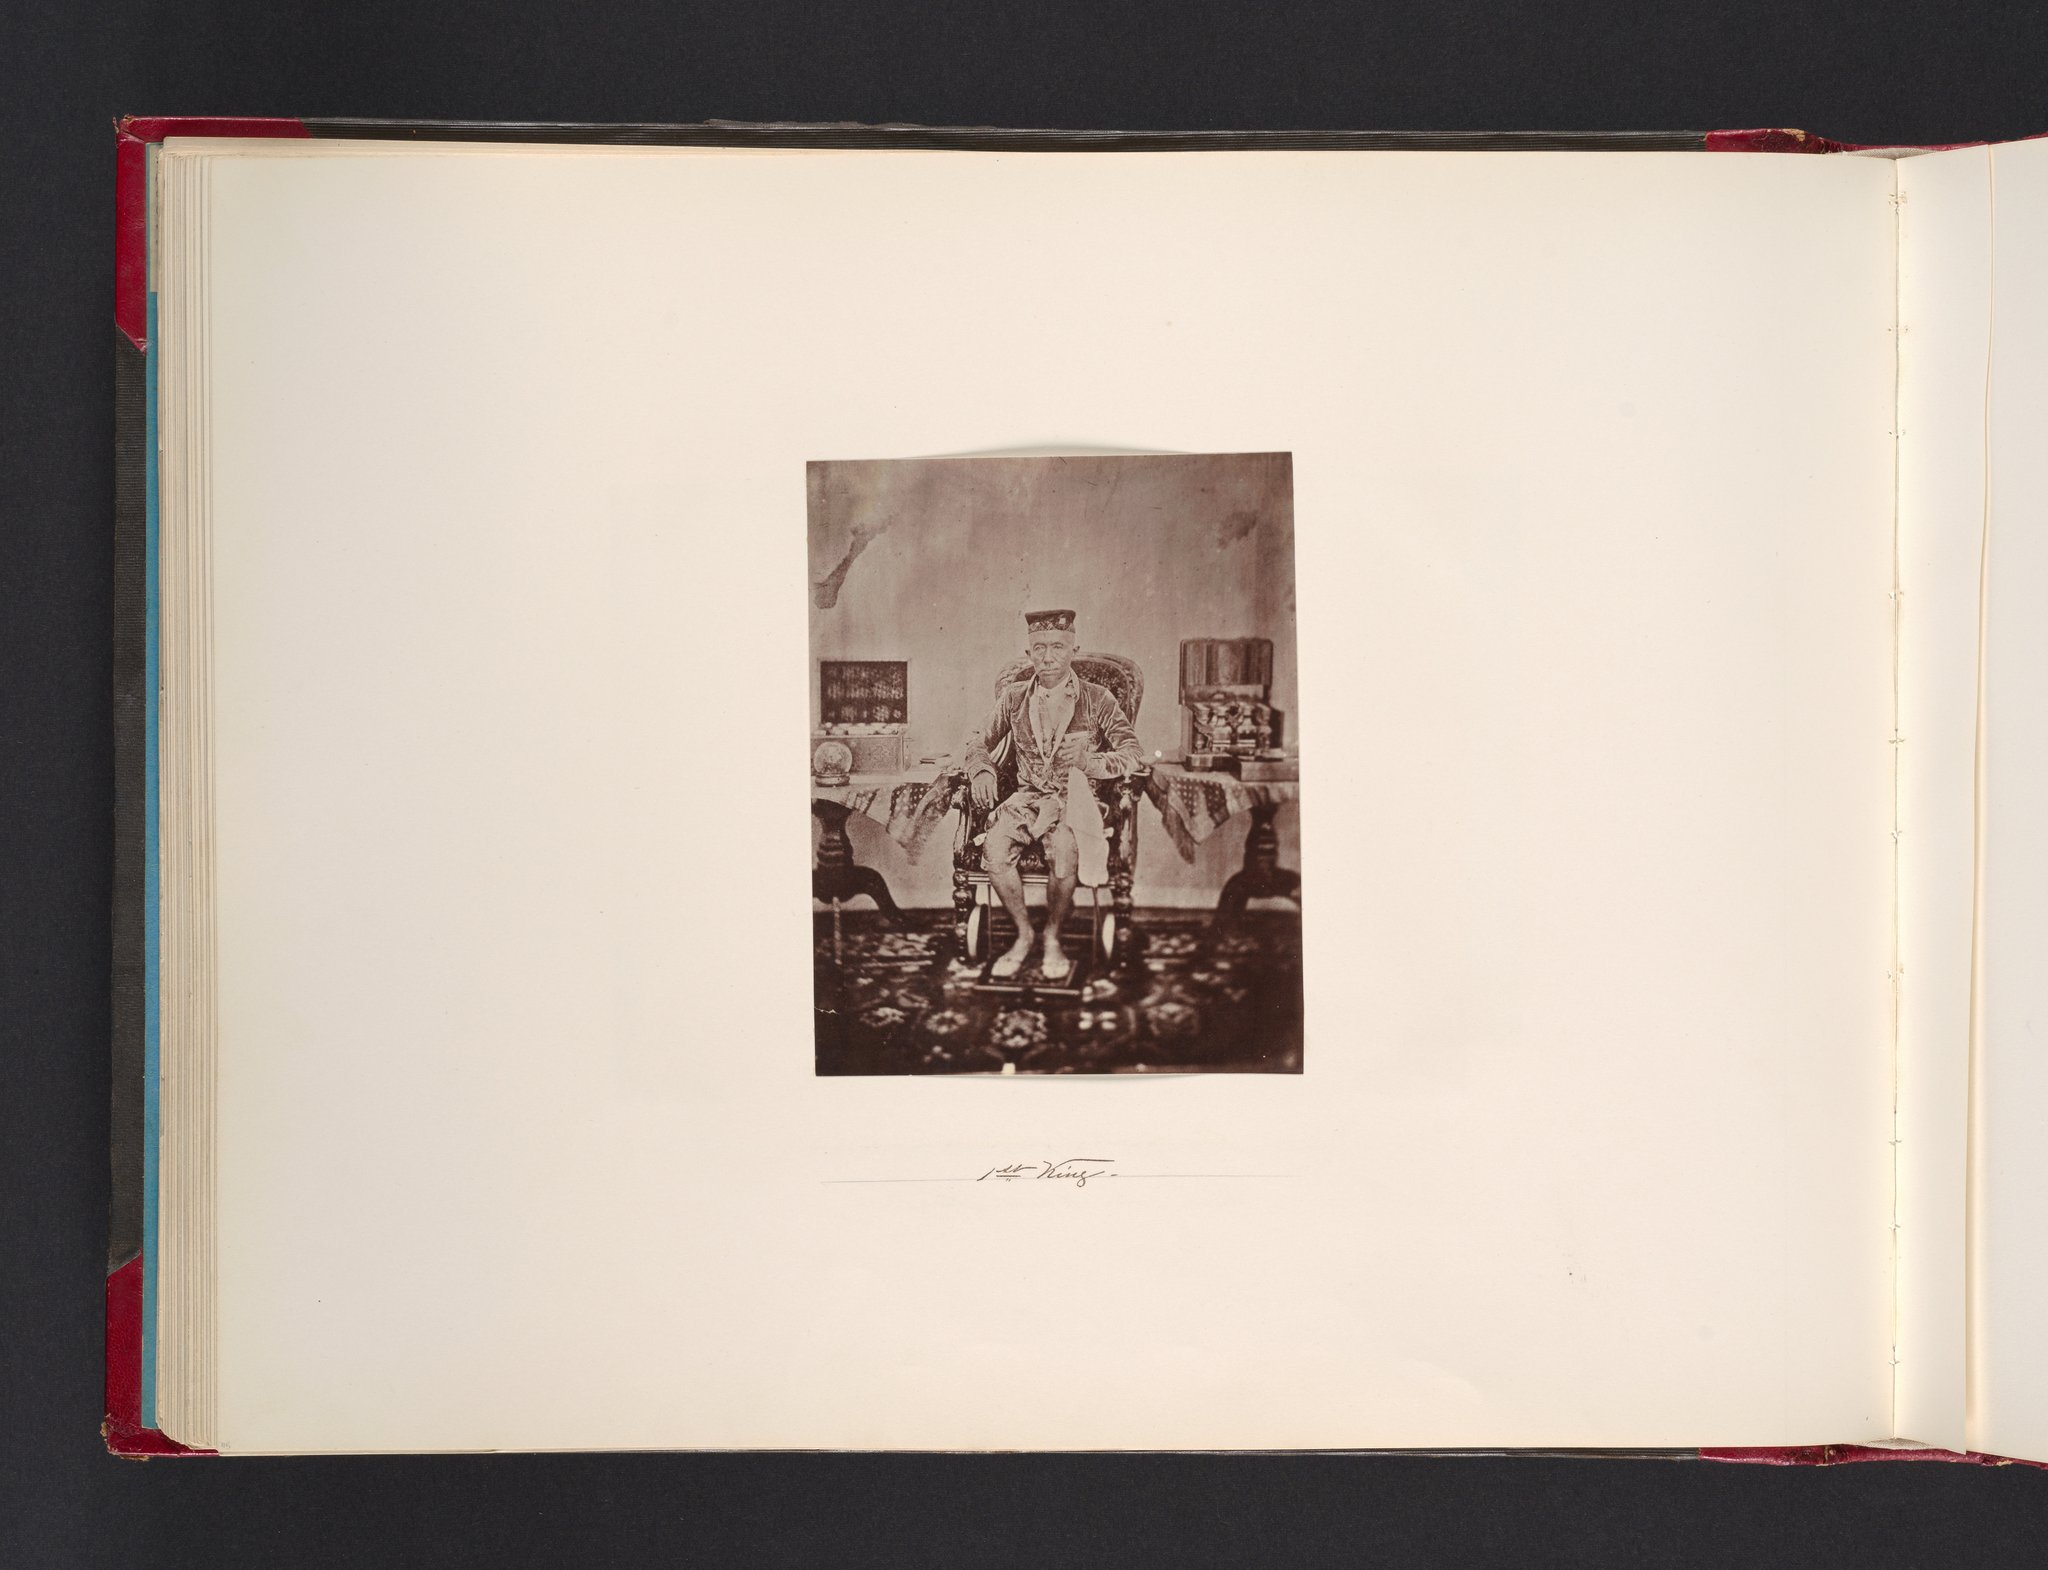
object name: photograph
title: 1st King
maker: john thomson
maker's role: artist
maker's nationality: british, scottish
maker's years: 1837-1921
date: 1865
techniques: albumen silver print, glass negative